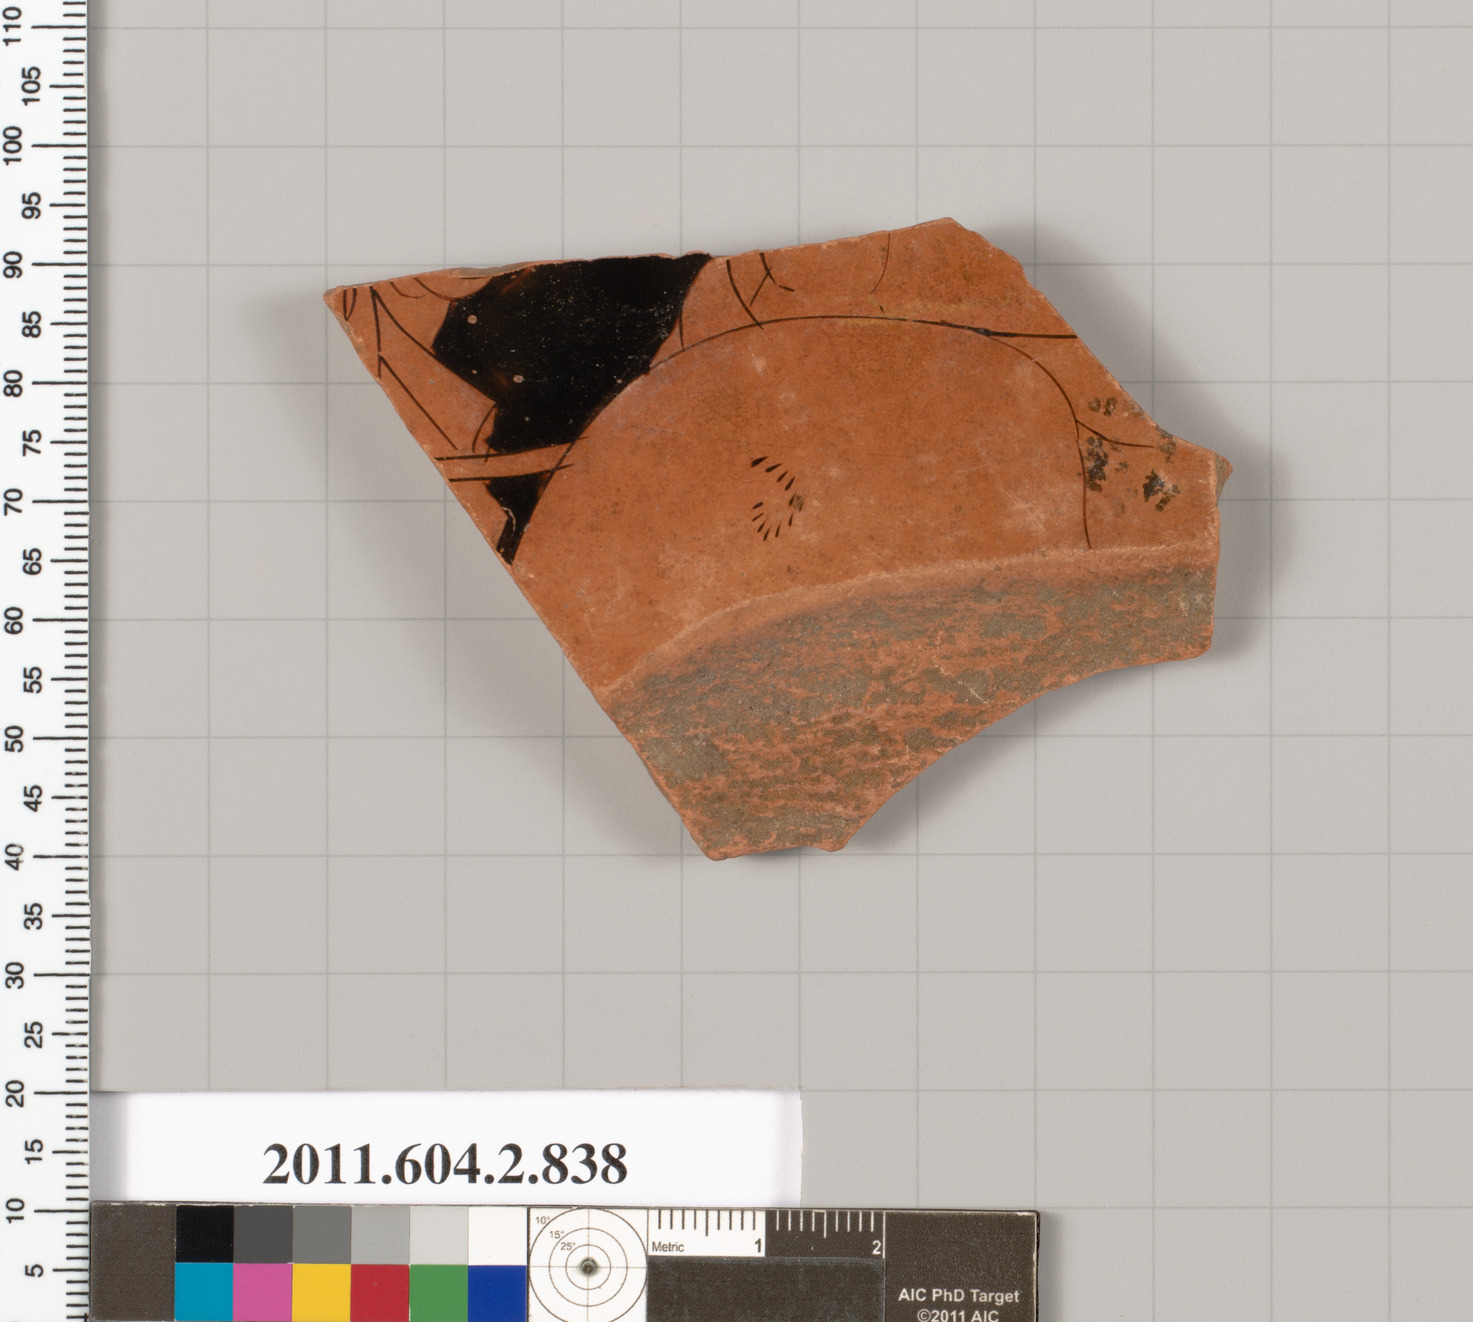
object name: bell krater fragment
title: Terracotta fragment of a bell-krater (bowl for mixing wine and water)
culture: greek, attic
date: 467-435 BCE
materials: terracotta